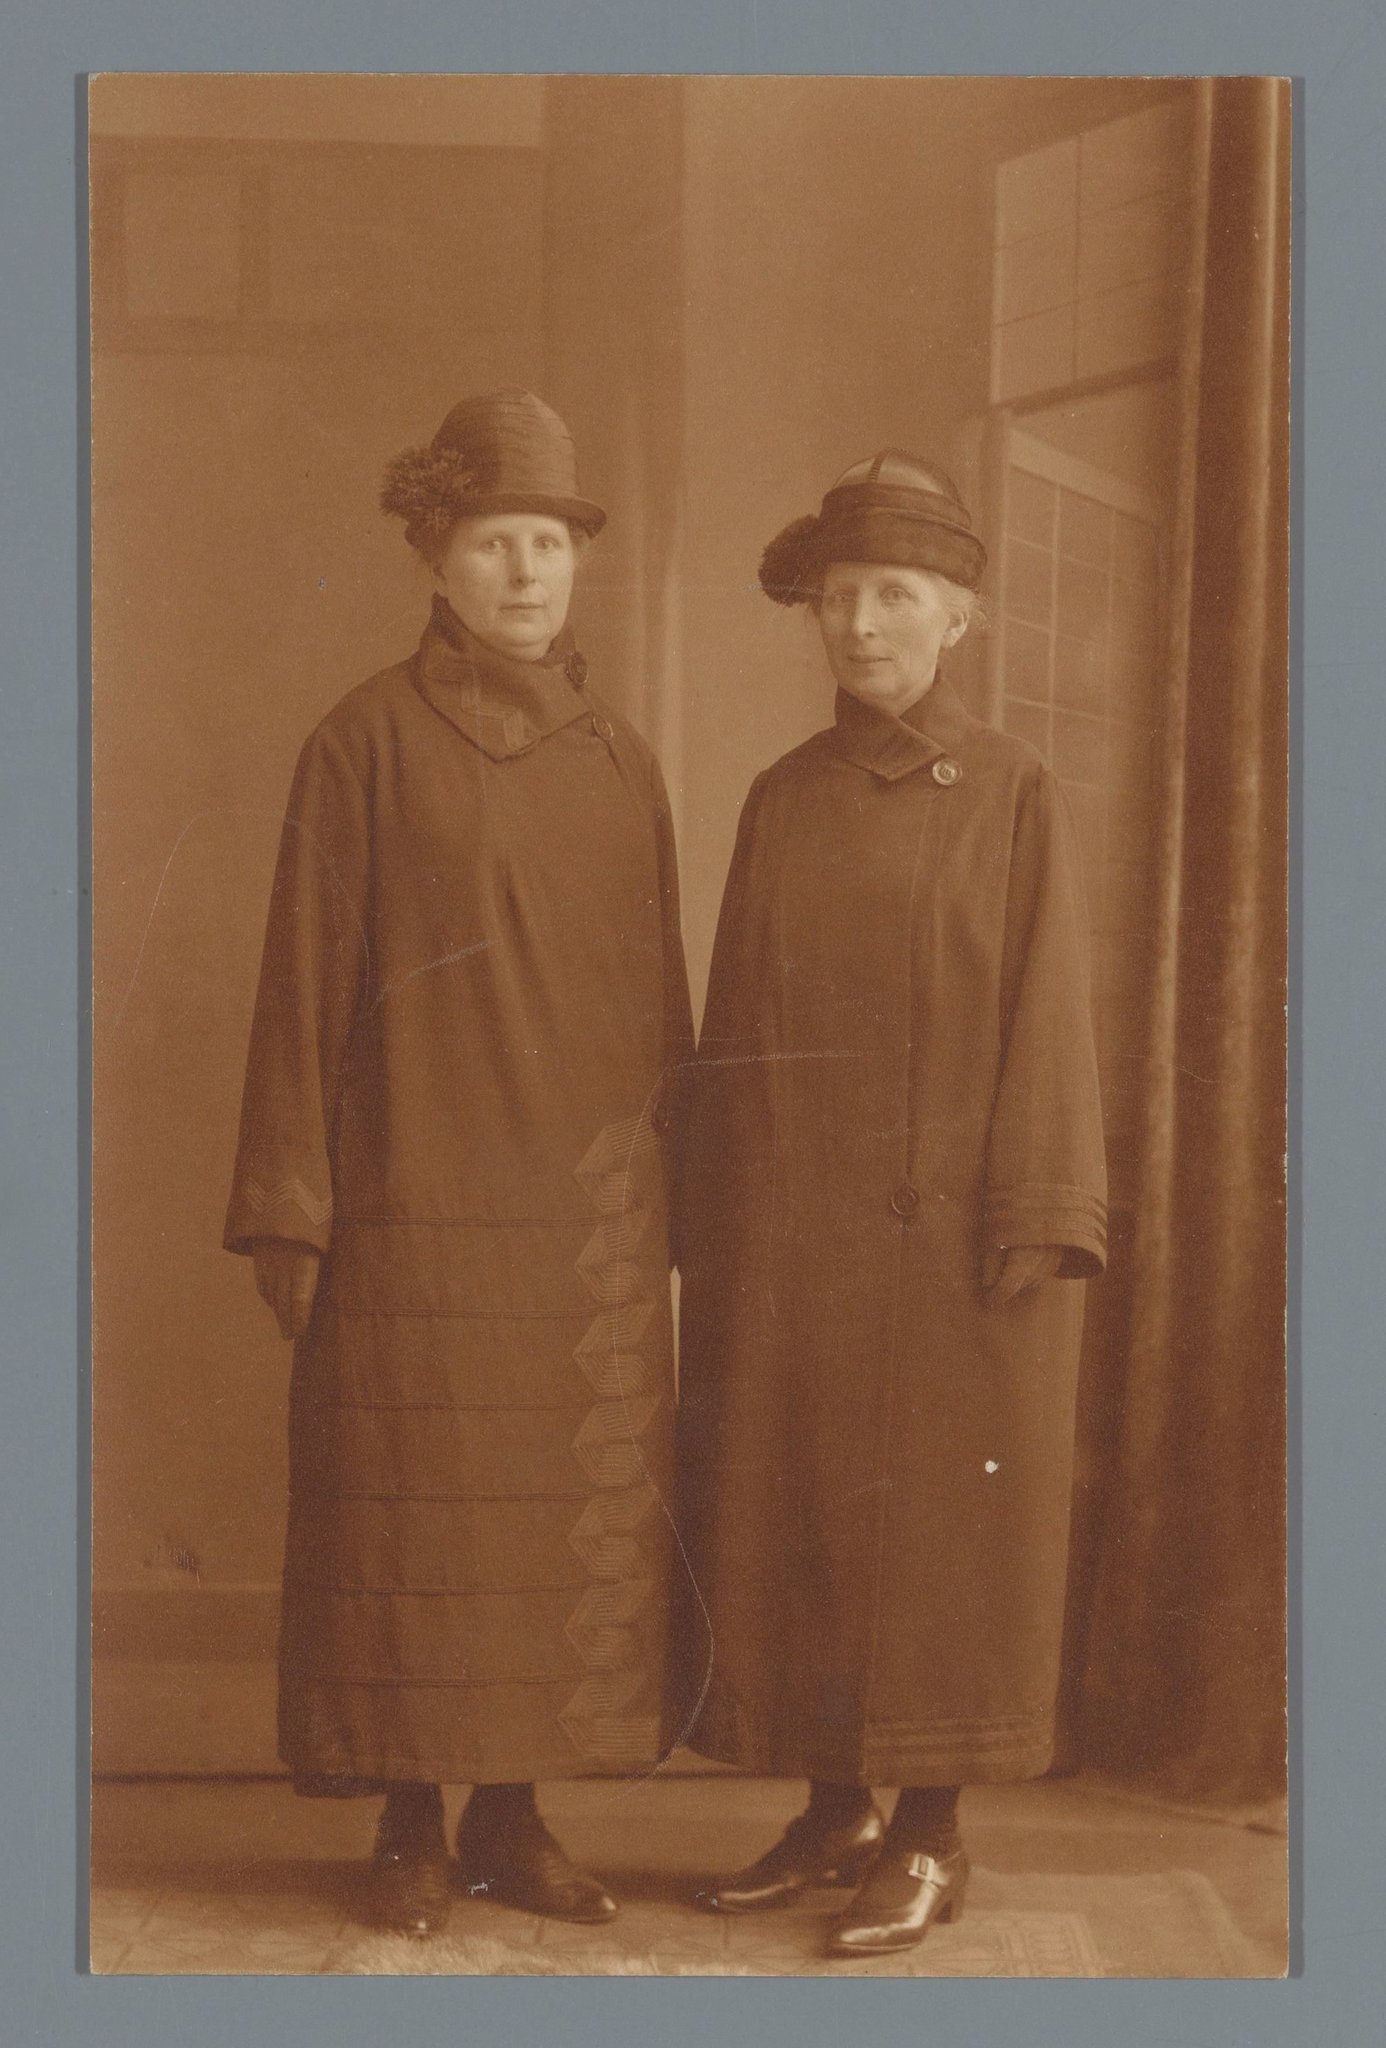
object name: ansichtkaart, prentbriefkaart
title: Portret van twee onbekende vrouwen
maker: Anonymous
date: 1910-1920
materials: photographic support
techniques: gelatin silver print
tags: adult woman